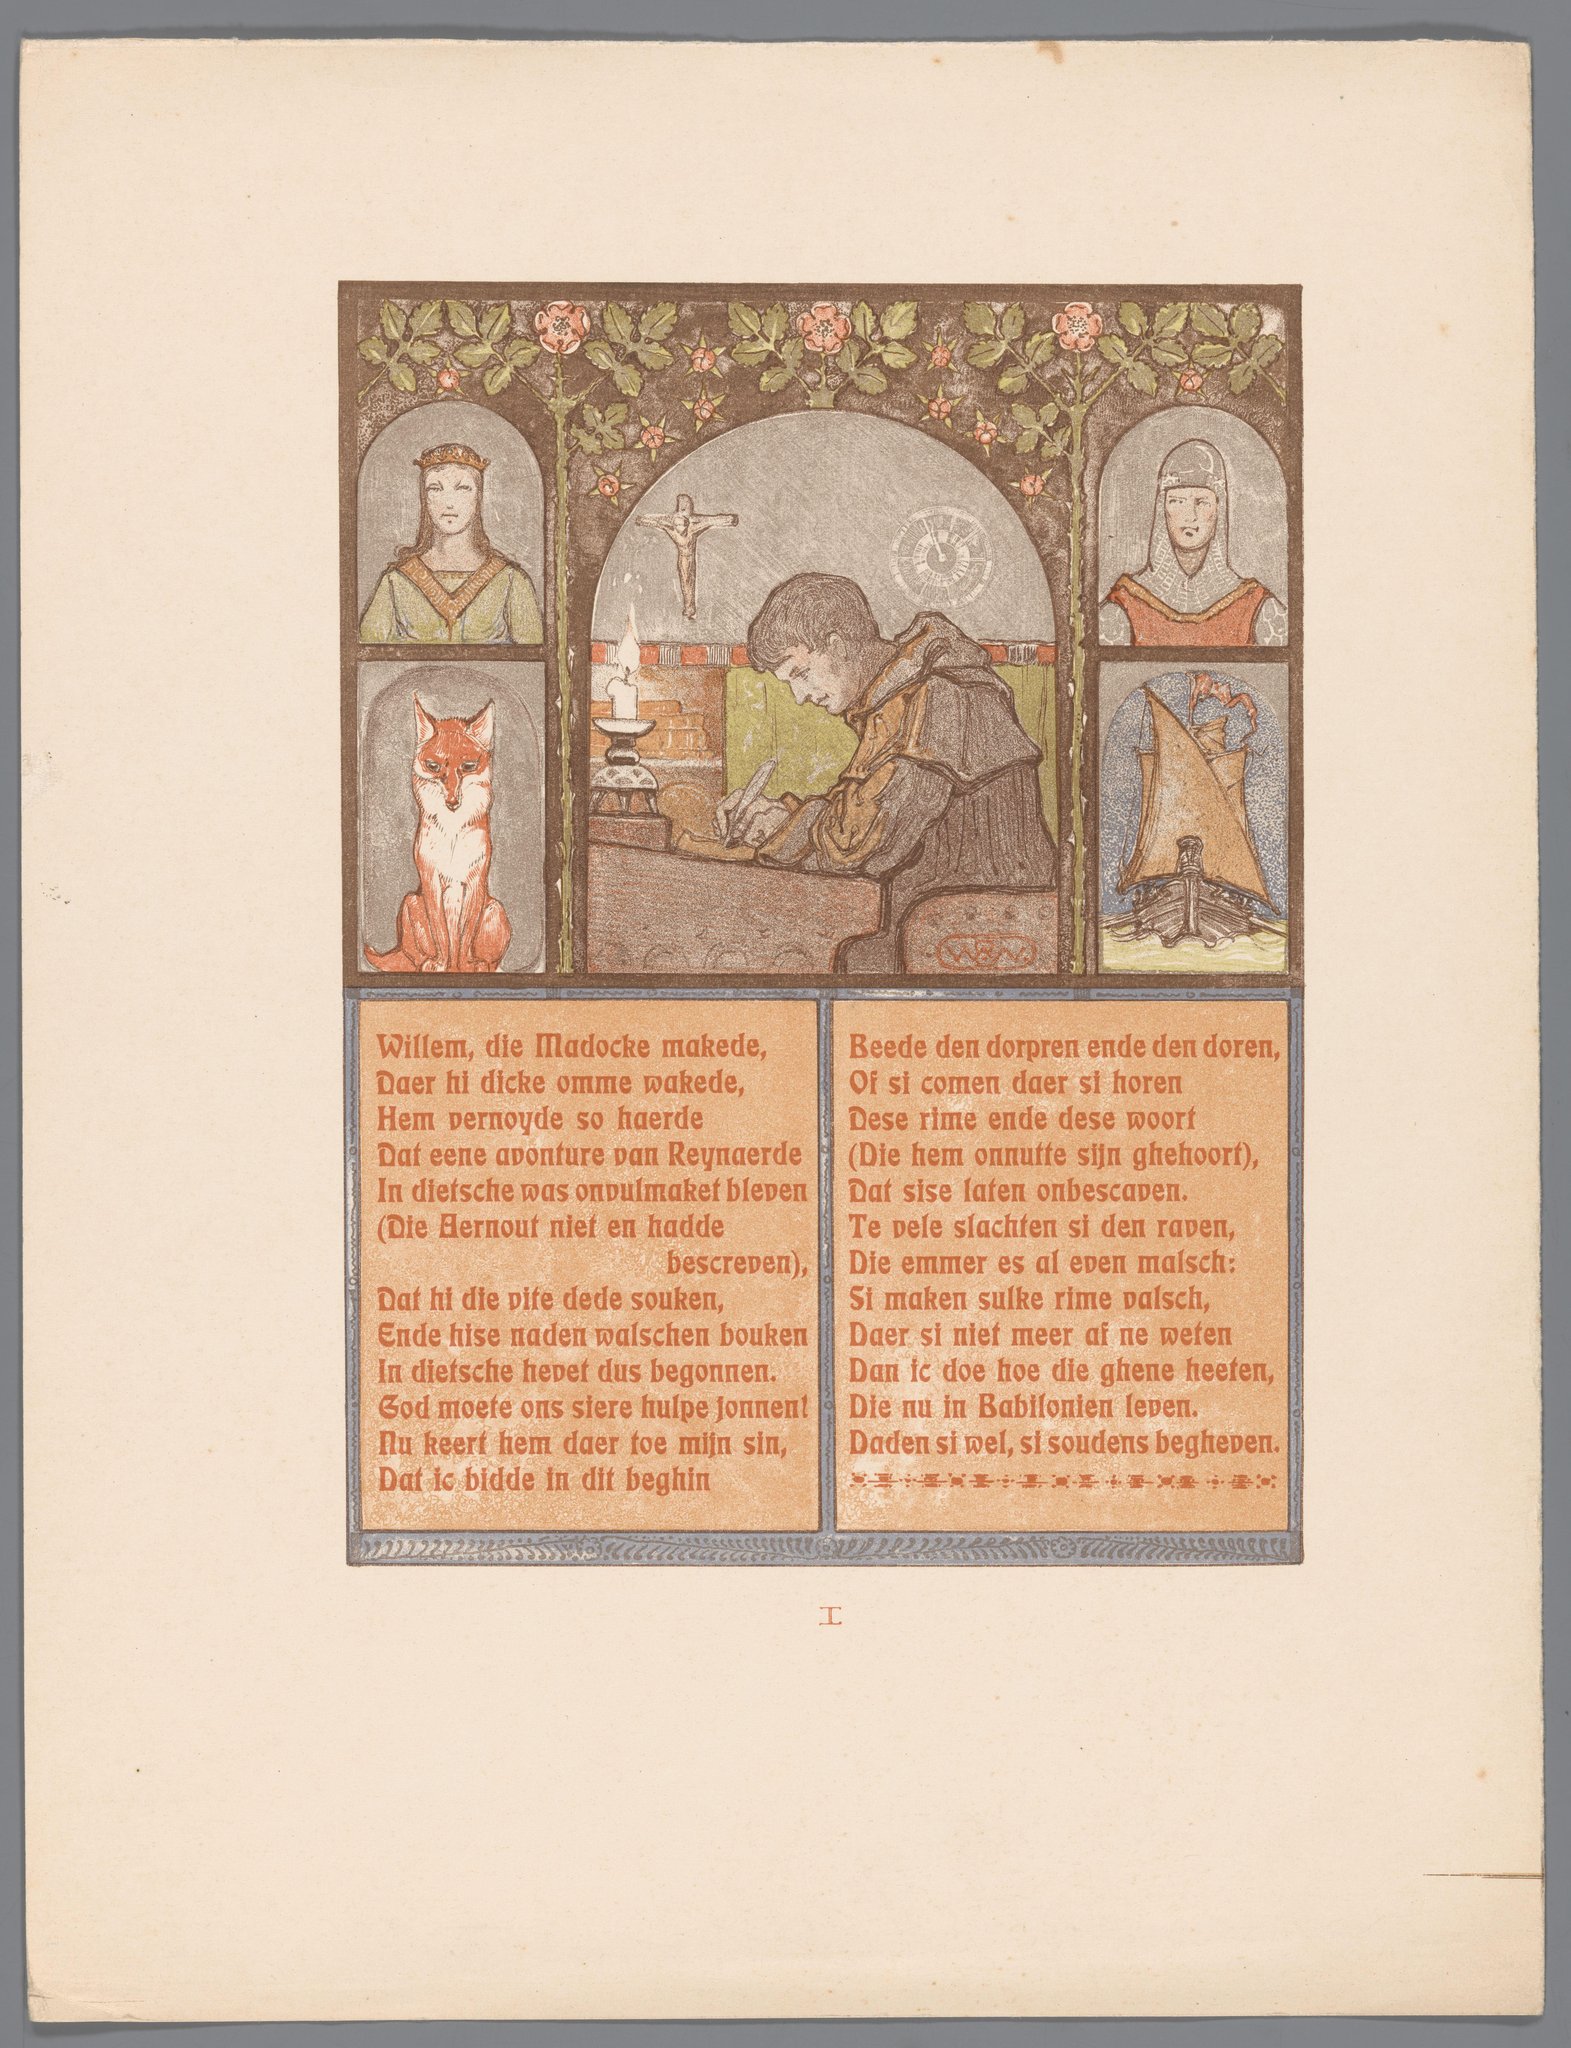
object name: print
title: Schrijvende monnik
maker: bernard willem wierink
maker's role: draughtsman, print maker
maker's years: 1856-1939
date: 1910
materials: paper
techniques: lithograph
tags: fable of reynard the fox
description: Prent gebruikt in: Streuvels, Stijn (Frank Lateur). Reinaert de Vos naar verschillende uitgaven van het middeleeuwsche epos. Amsterdam: L.J. Veen, 1910.